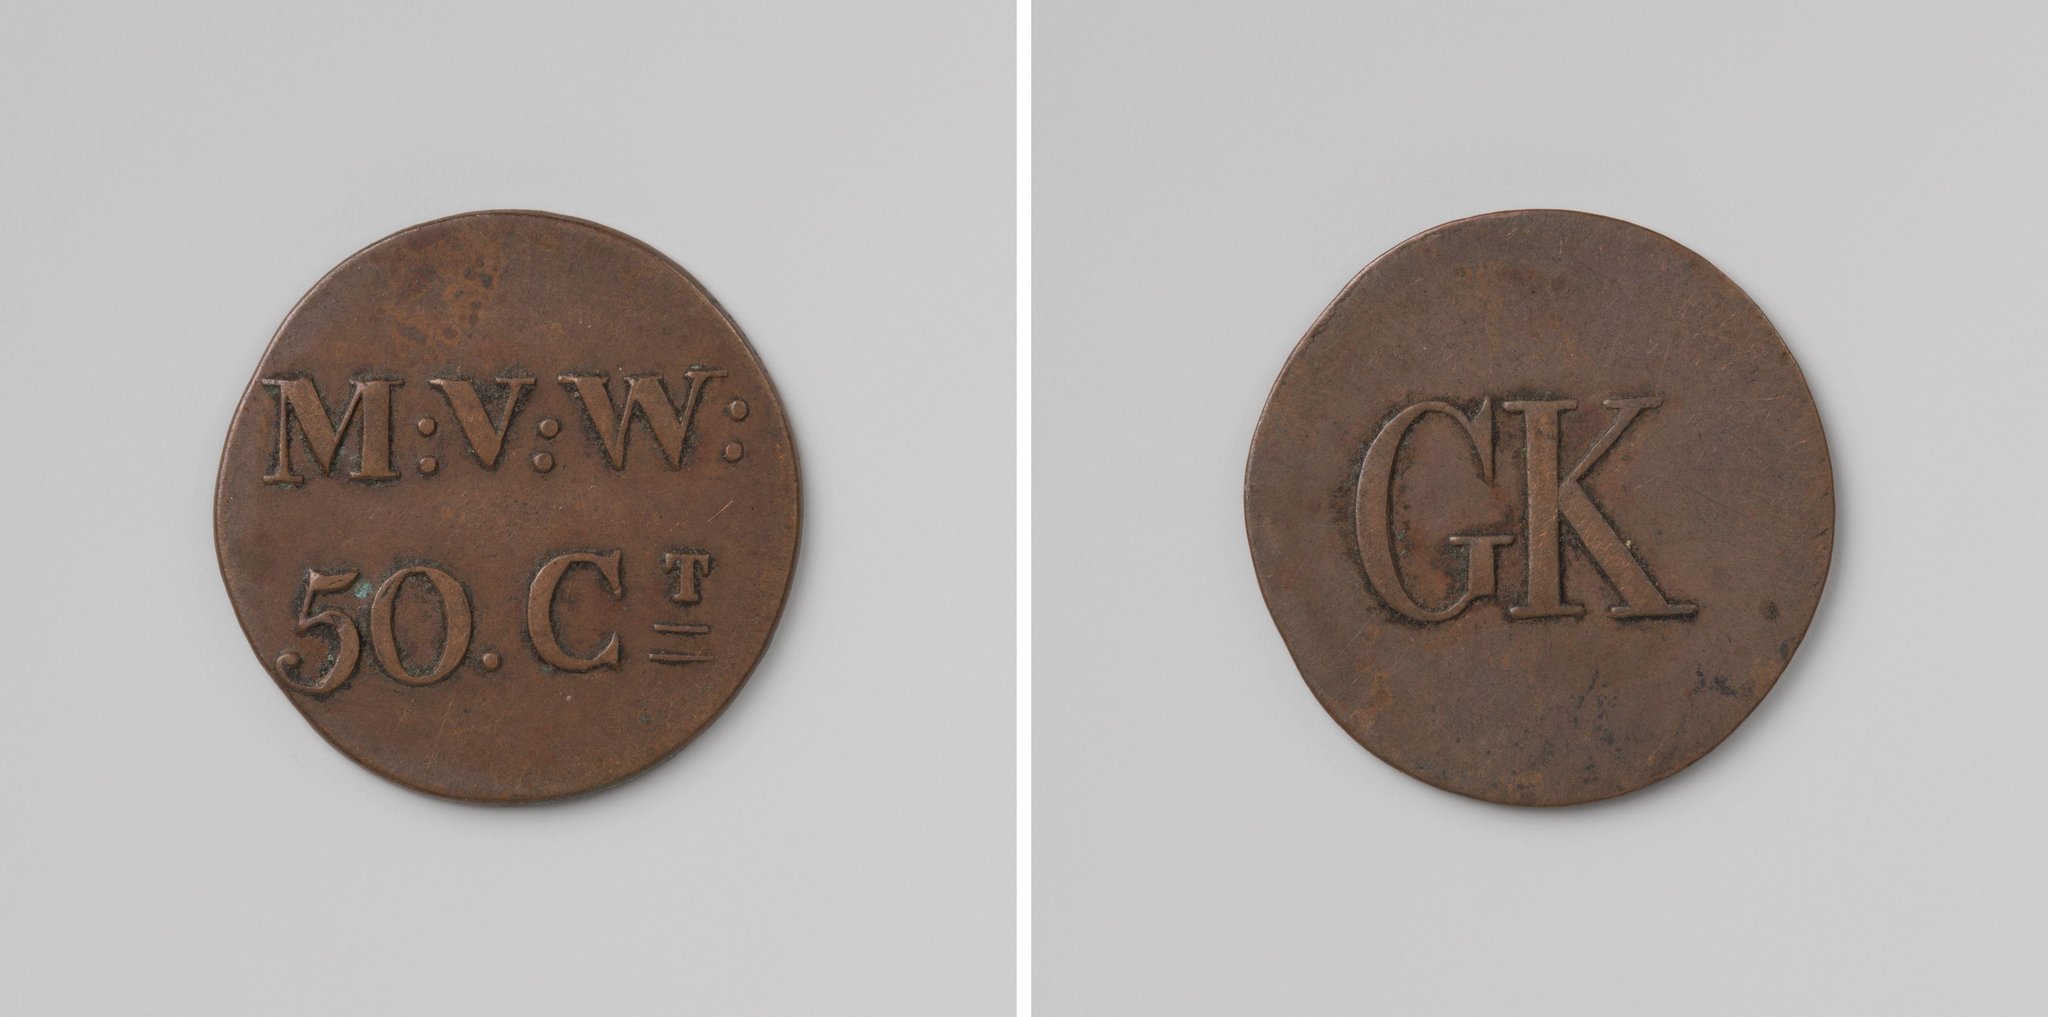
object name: monetary token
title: Huismunt geslagen op last van de Maatschappij van Weldadigheid ter waarde van 50 cent, ten behoeve van de Gewone Koloniën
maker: Anonymous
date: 1818-1859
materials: copper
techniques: striking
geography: netherlands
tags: maatschappij van weldadigheid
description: Voorzijde: opschrift boven waardeaanduiding. Keerzijde: opschrift G en K